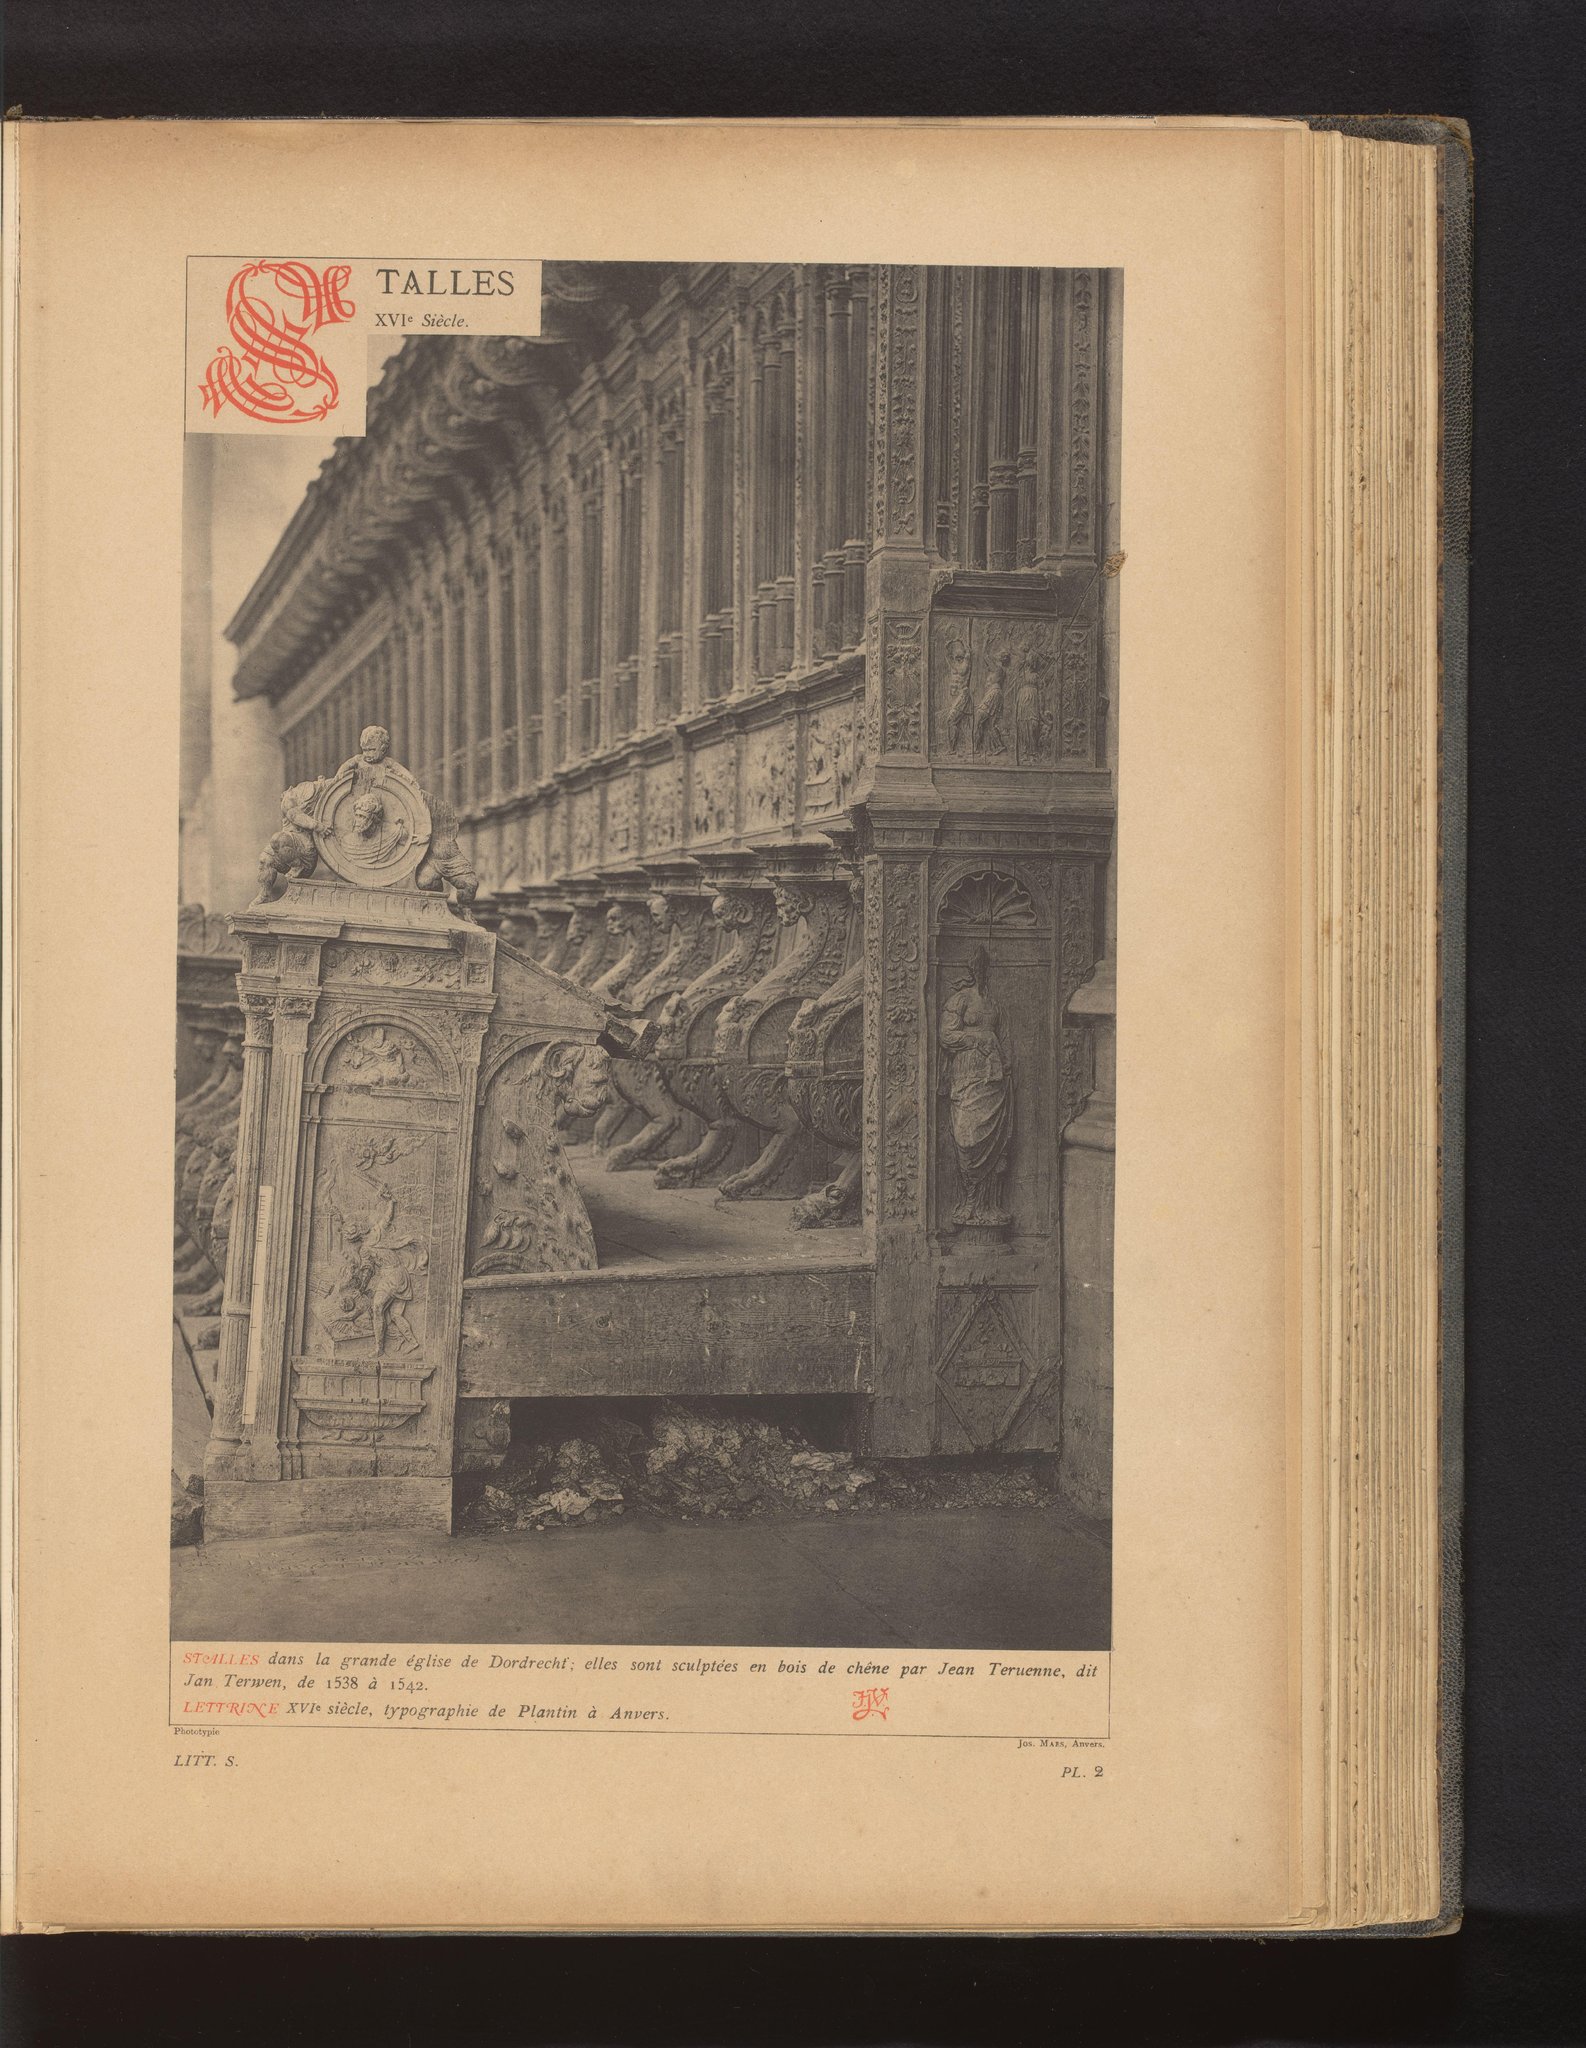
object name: photomechanical print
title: Koorgestoelte in de Grote of Onze-Lieve-Vrouwekerk te Dordrecht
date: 1876-1881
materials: paper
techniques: photograph, photolithography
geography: dordrecht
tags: seats of the clergy, choir-stalls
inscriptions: inscription: ‘STALLES dans la (...)’, inscription: ‘LITT. S. - PL. 2.’, monogram: ‘JJvY’